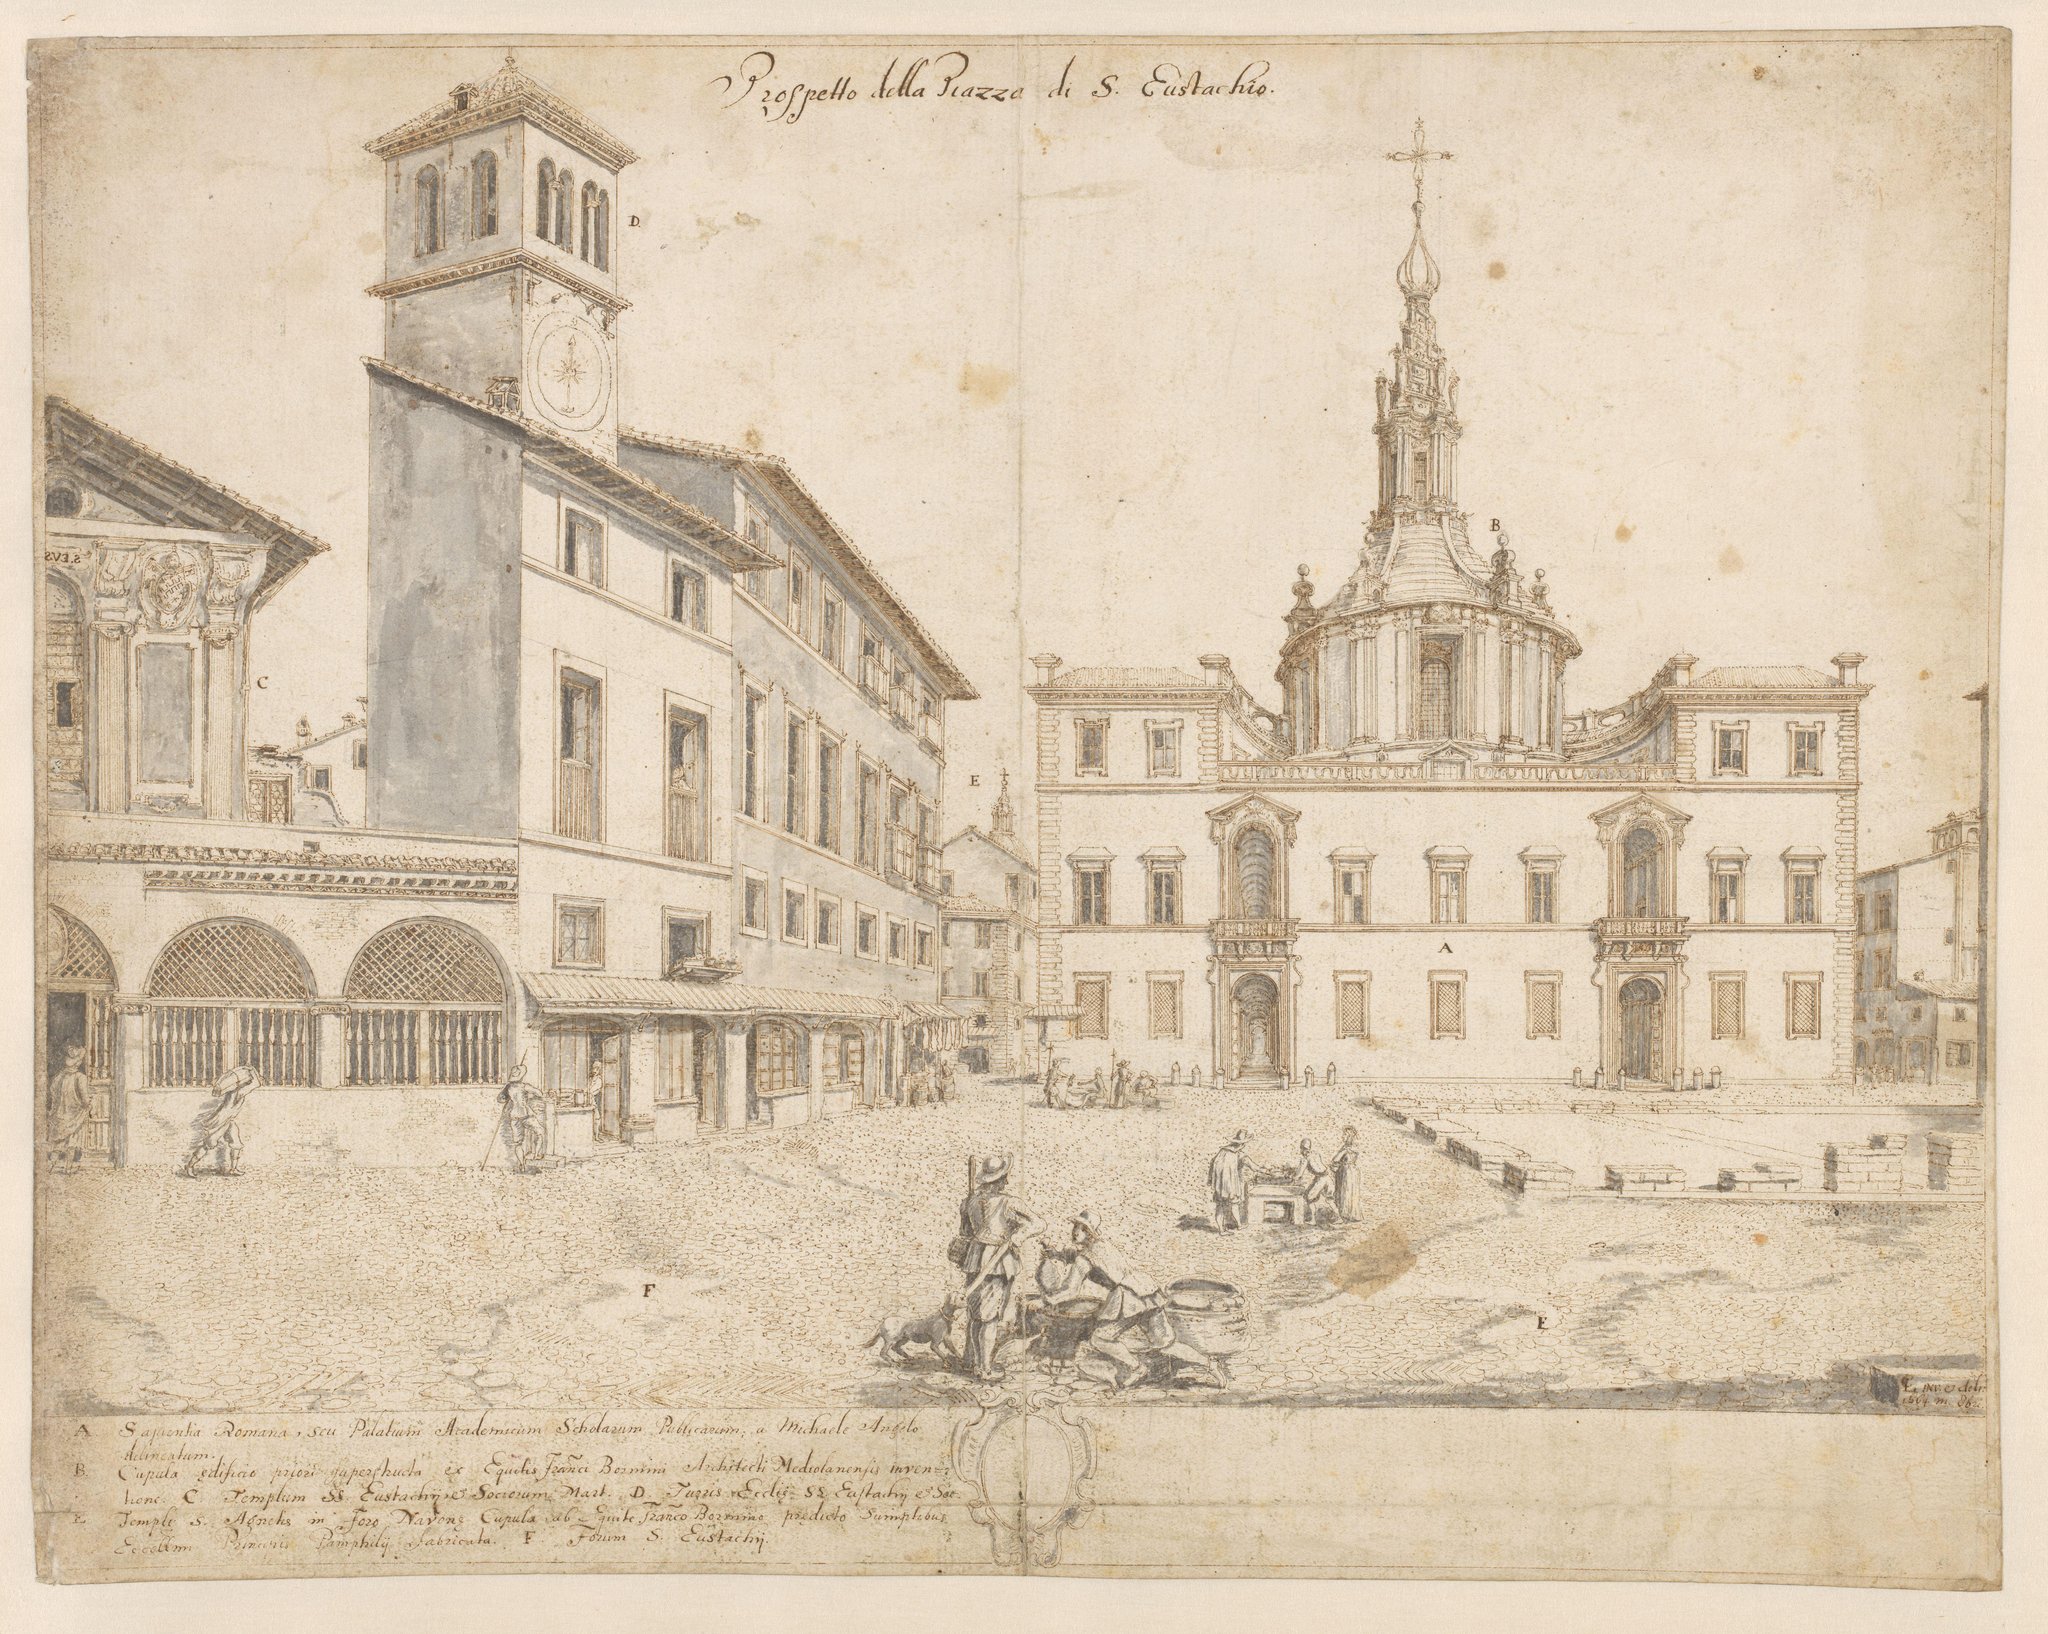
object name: drawing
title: Gezicht te Rome van de Piazza S. Eustachio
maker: lievin cruyl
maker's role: draughtsman, print maker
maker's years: 1634-1720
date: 1664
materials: ink, paper, pencil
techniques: brush, pen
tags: square, place, circus, etc.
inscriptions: : ‘Prospetto della Piazza di S. Eustachio’, date: ‘1664’